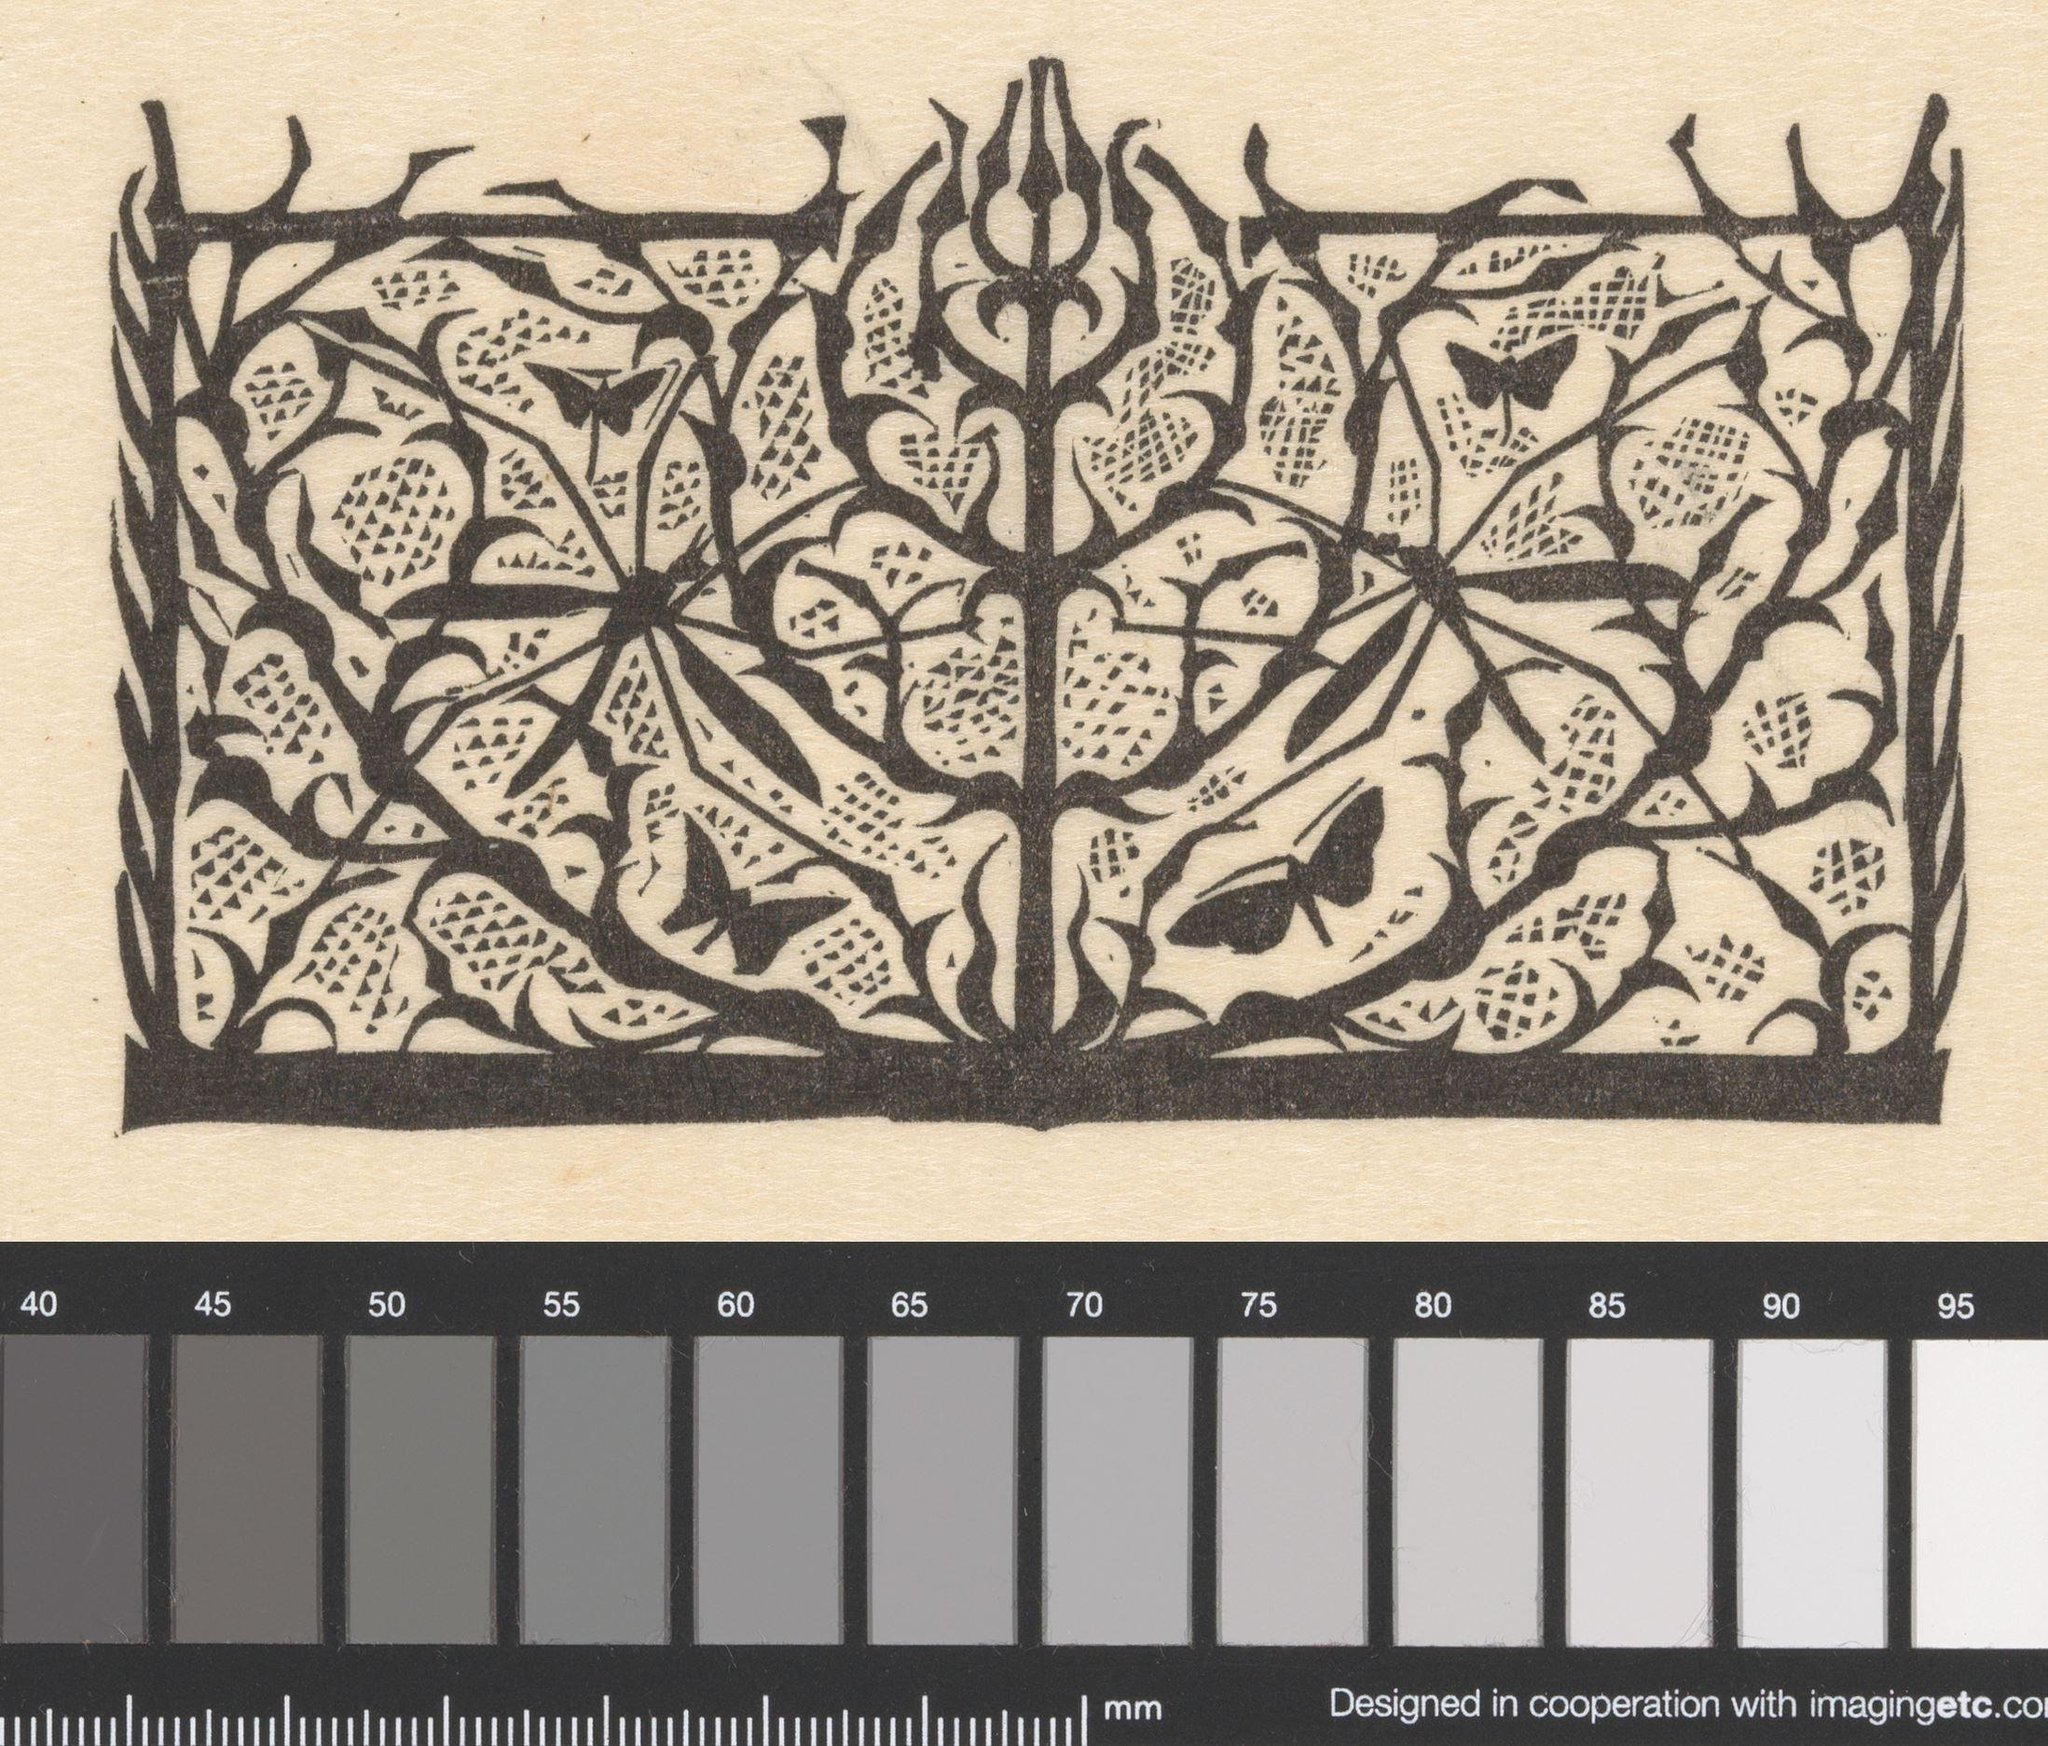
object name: print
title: Titelhoofd met langpootmuggen en motten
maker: gerrit willem dijsselhof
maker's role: designer, draughtsman, print maker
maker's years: 1866-1924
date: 1893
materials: paper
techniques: woodcut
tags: insects: moth, insects: mosquito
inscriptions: collector's mark: Lugt 2228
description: Prent gebruikt voor: Crane, Walter [vertaling: Veth, Jan]. Kunst en samenleving. Amsterdam: Scheltema & Holkema’s Boekhandel, 1893.